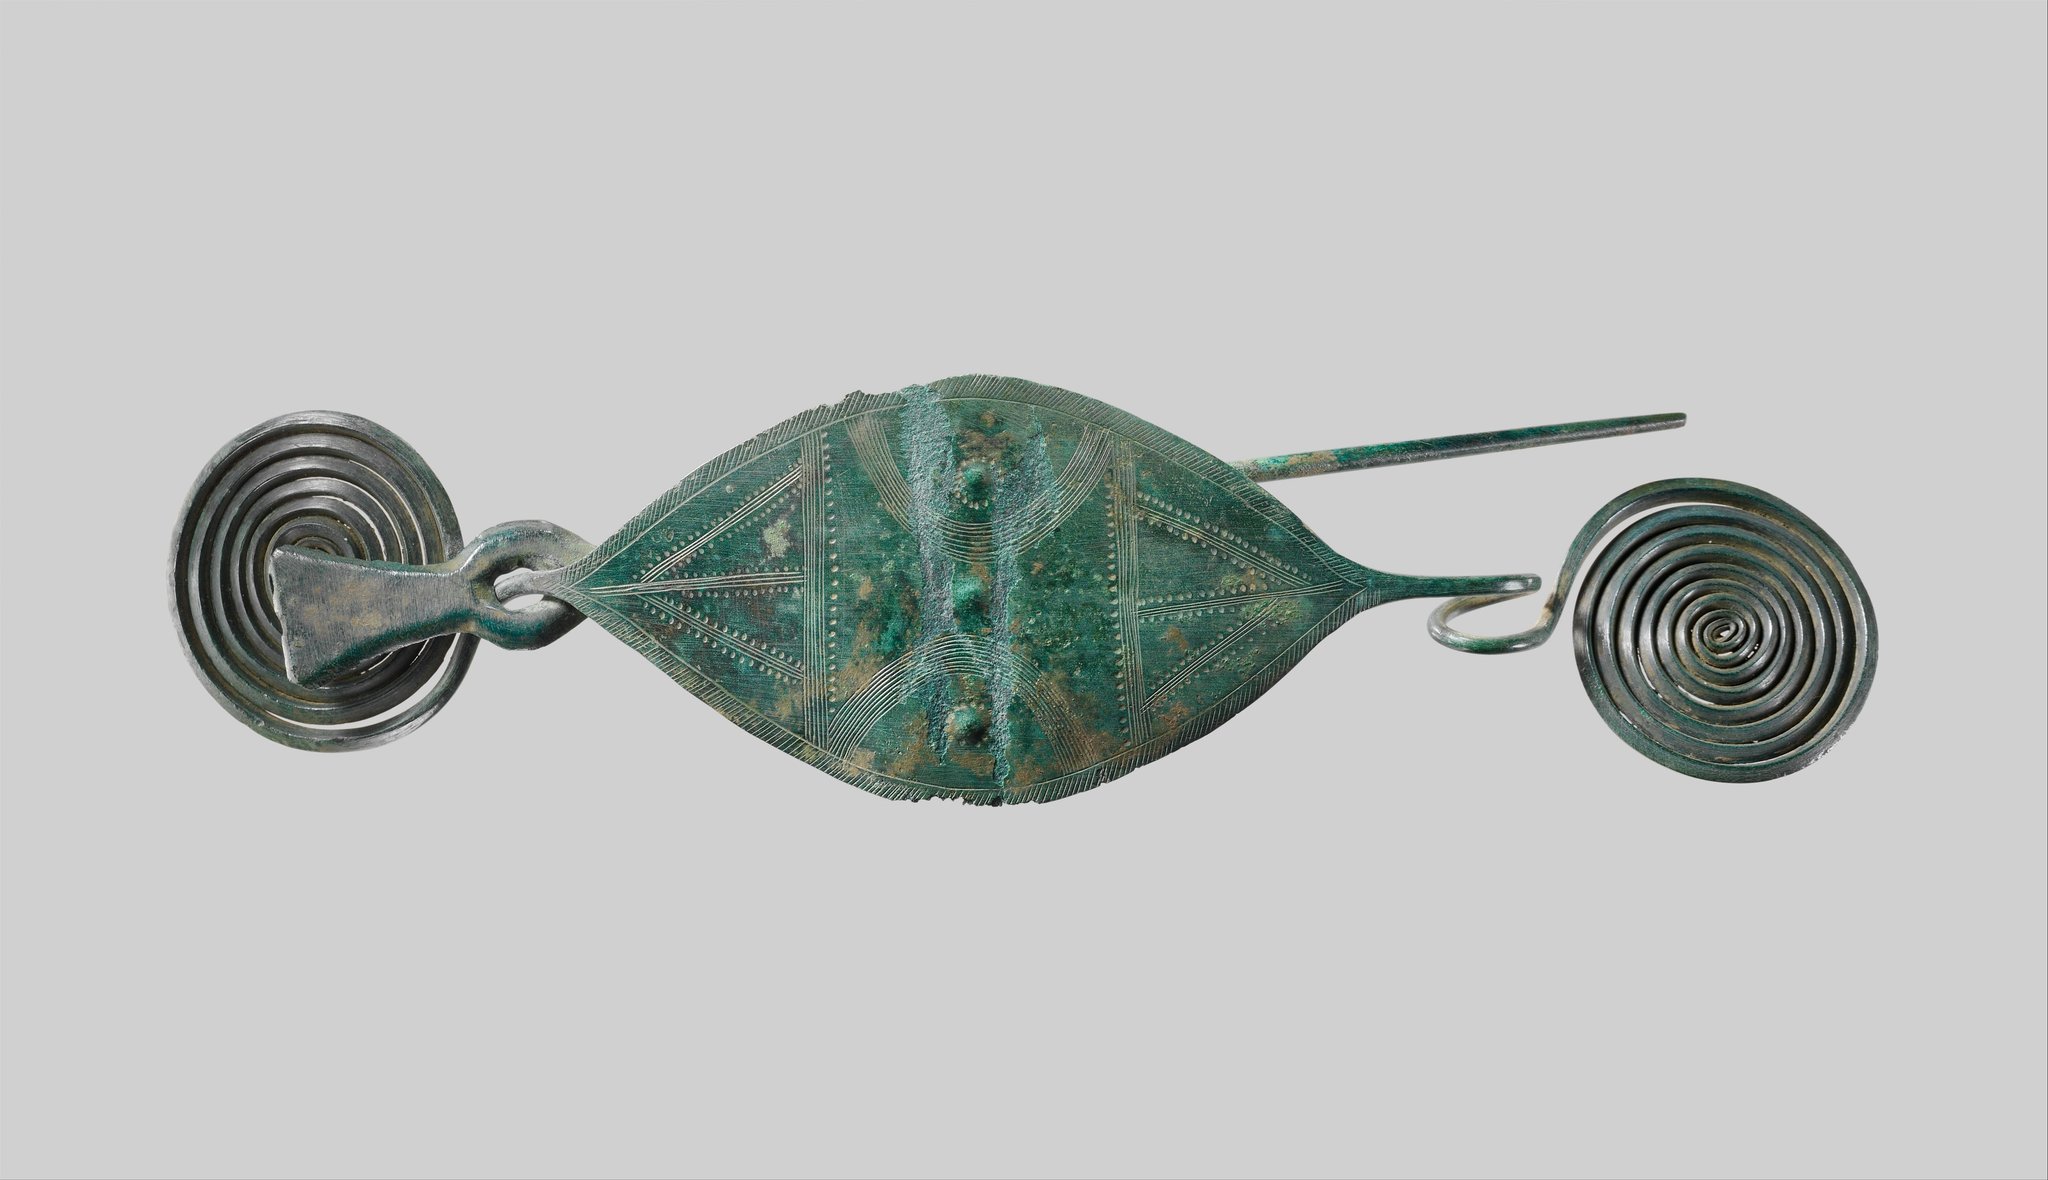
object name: brooch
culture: european bronze age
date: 1100-1001 BCE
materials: copper alloy